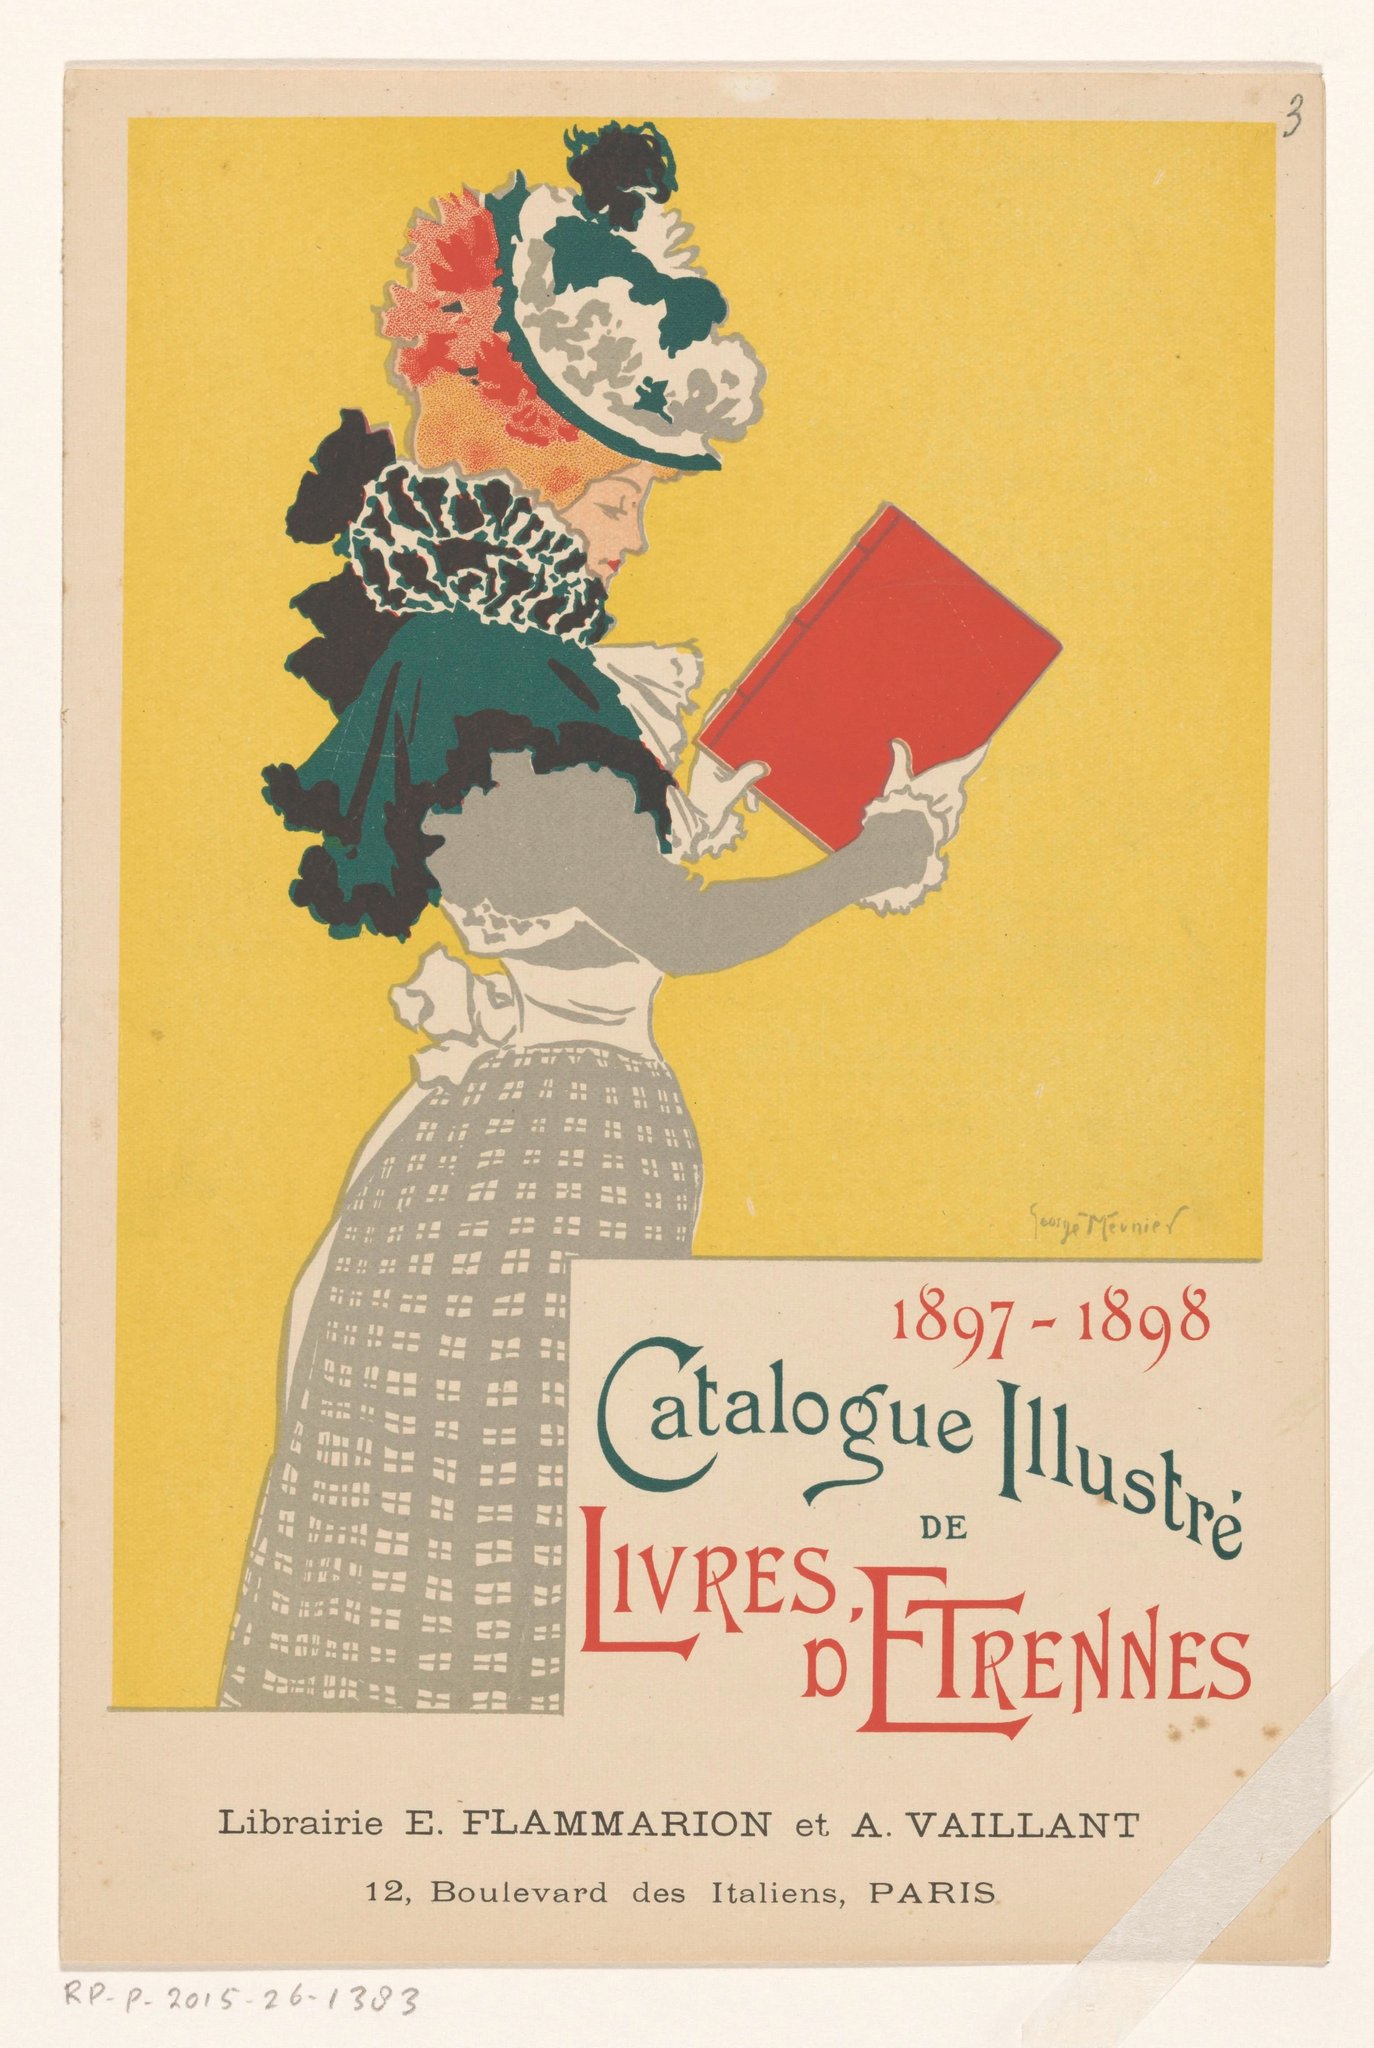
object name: print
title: Vrouw bekijkt de rug van een boek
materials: paper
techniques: lithograph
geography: paris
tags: reading, book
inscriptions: collector's mark: Lugt 4780, collector's mark: Lugt 2228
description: Een staande vrouw met een hoed op haar hoofd bekijkt de rug van een boek dat ze met twee handen vast heeft. Op de achterzijde van de fondslijst staat een man met een zeis.